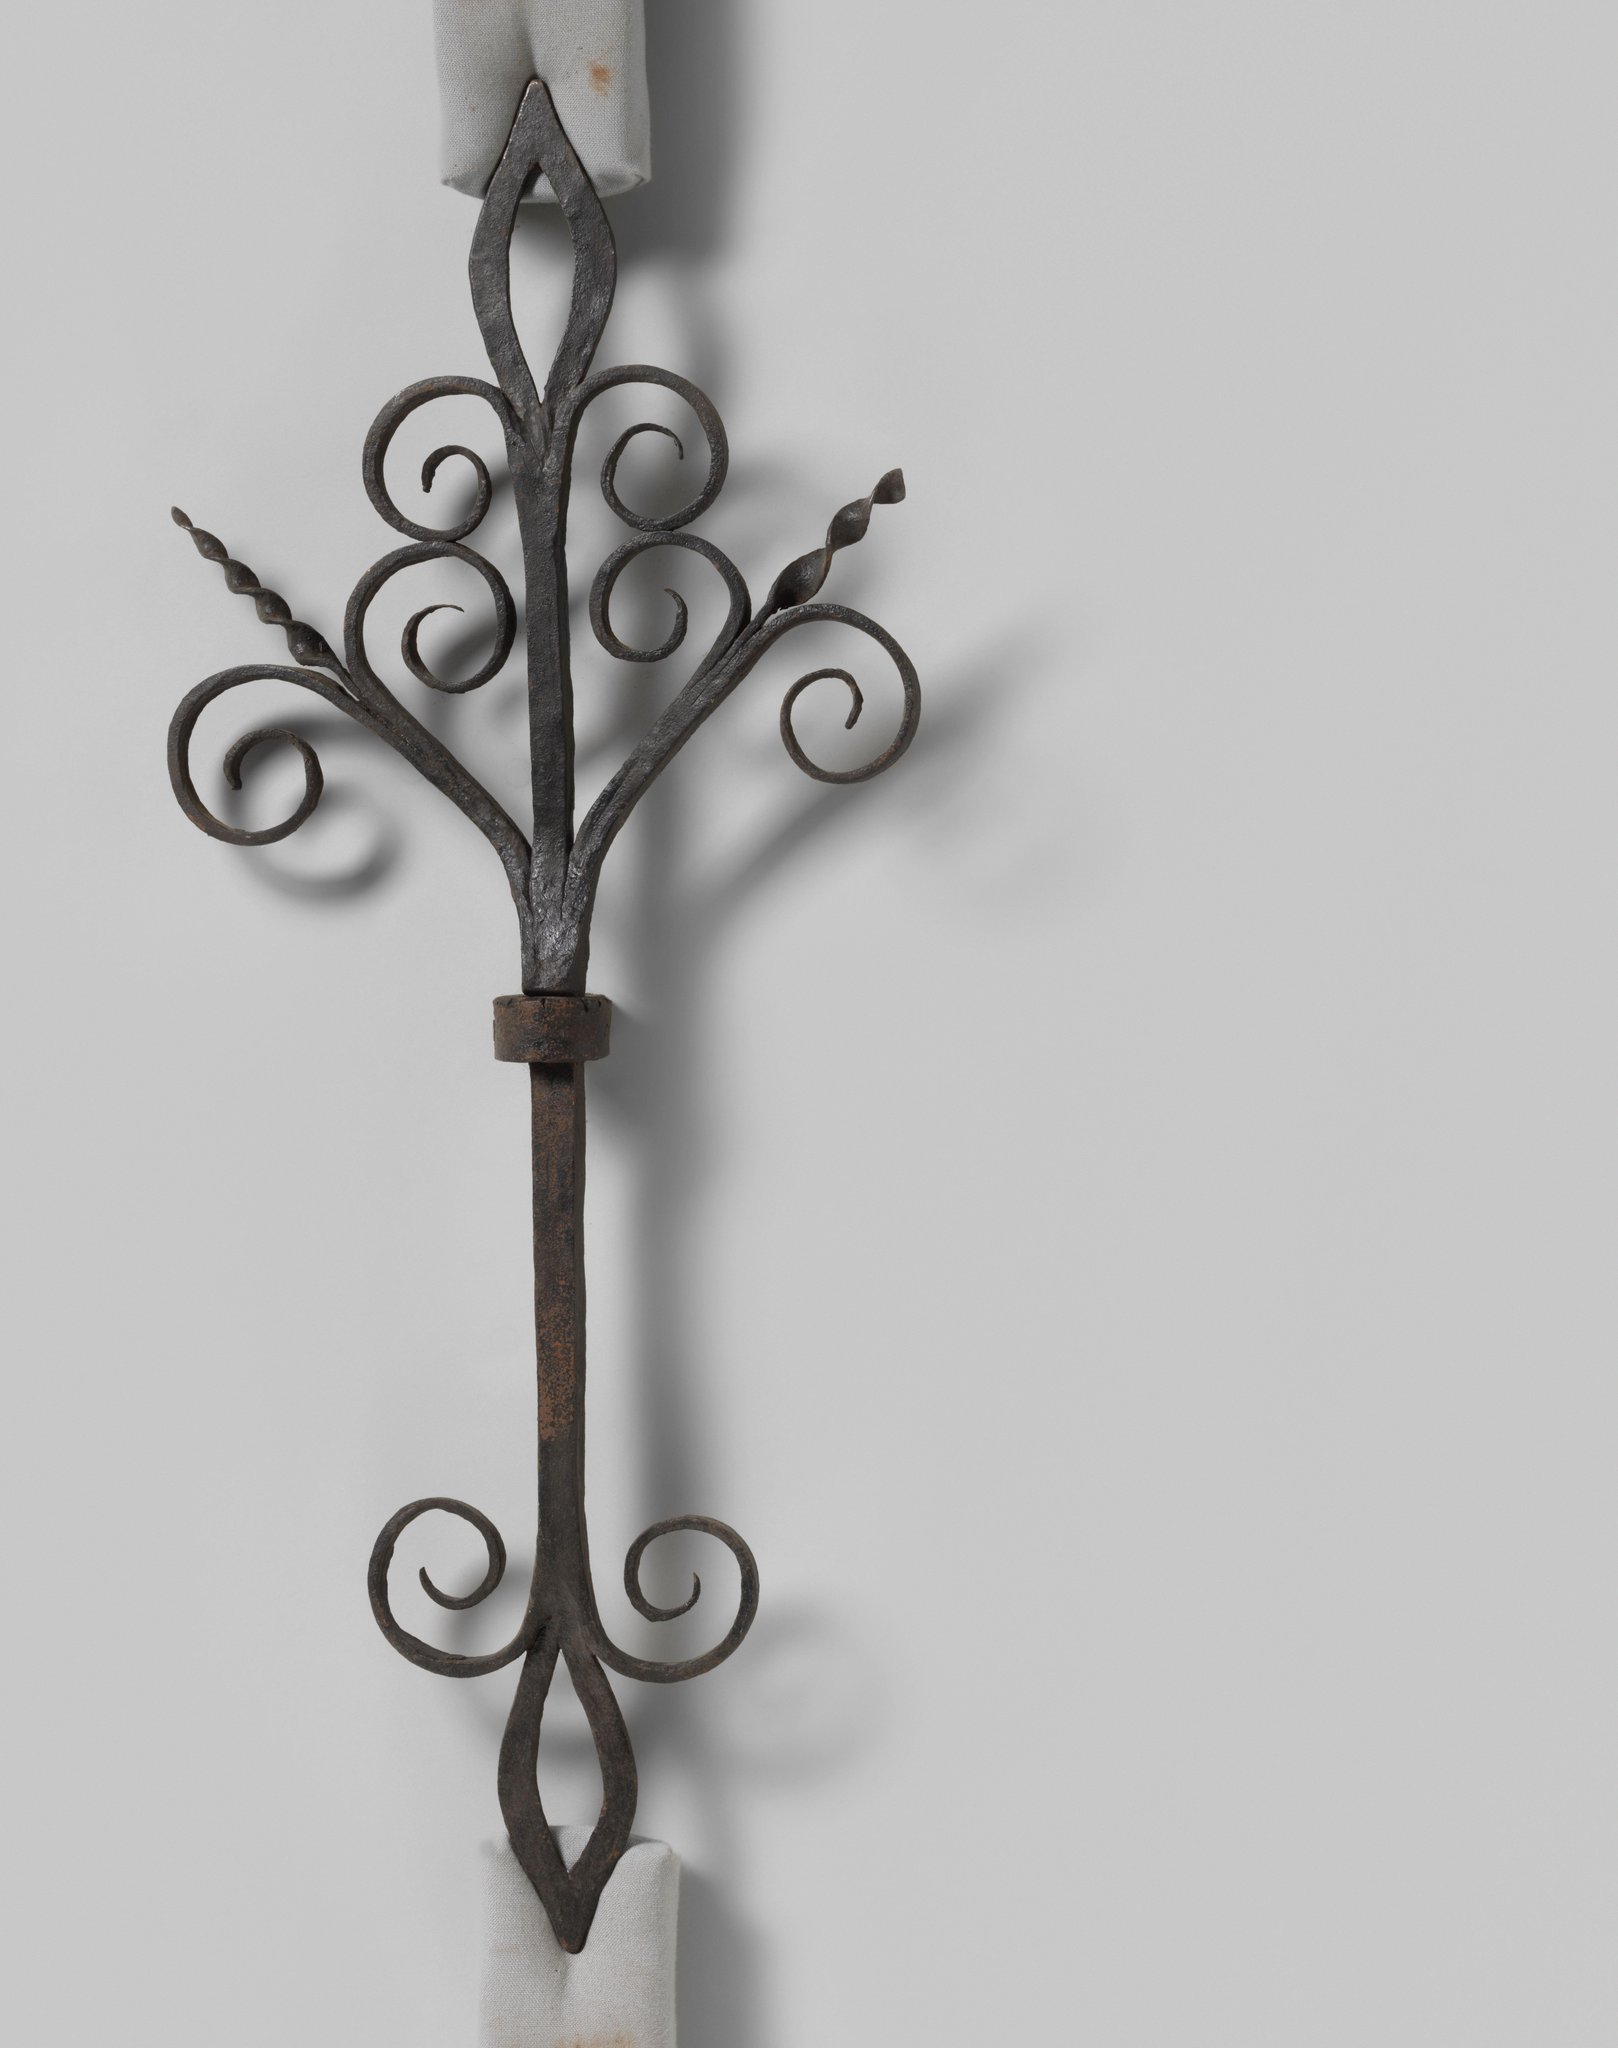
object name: beam anchor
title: Gevelanker afkomstig van woonhuis te Hattem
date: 1600-1699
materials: iron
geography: hattem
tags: hattem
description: Een gevelanker van een gesloopt 17de eeuwse woonhuis te Hattem.